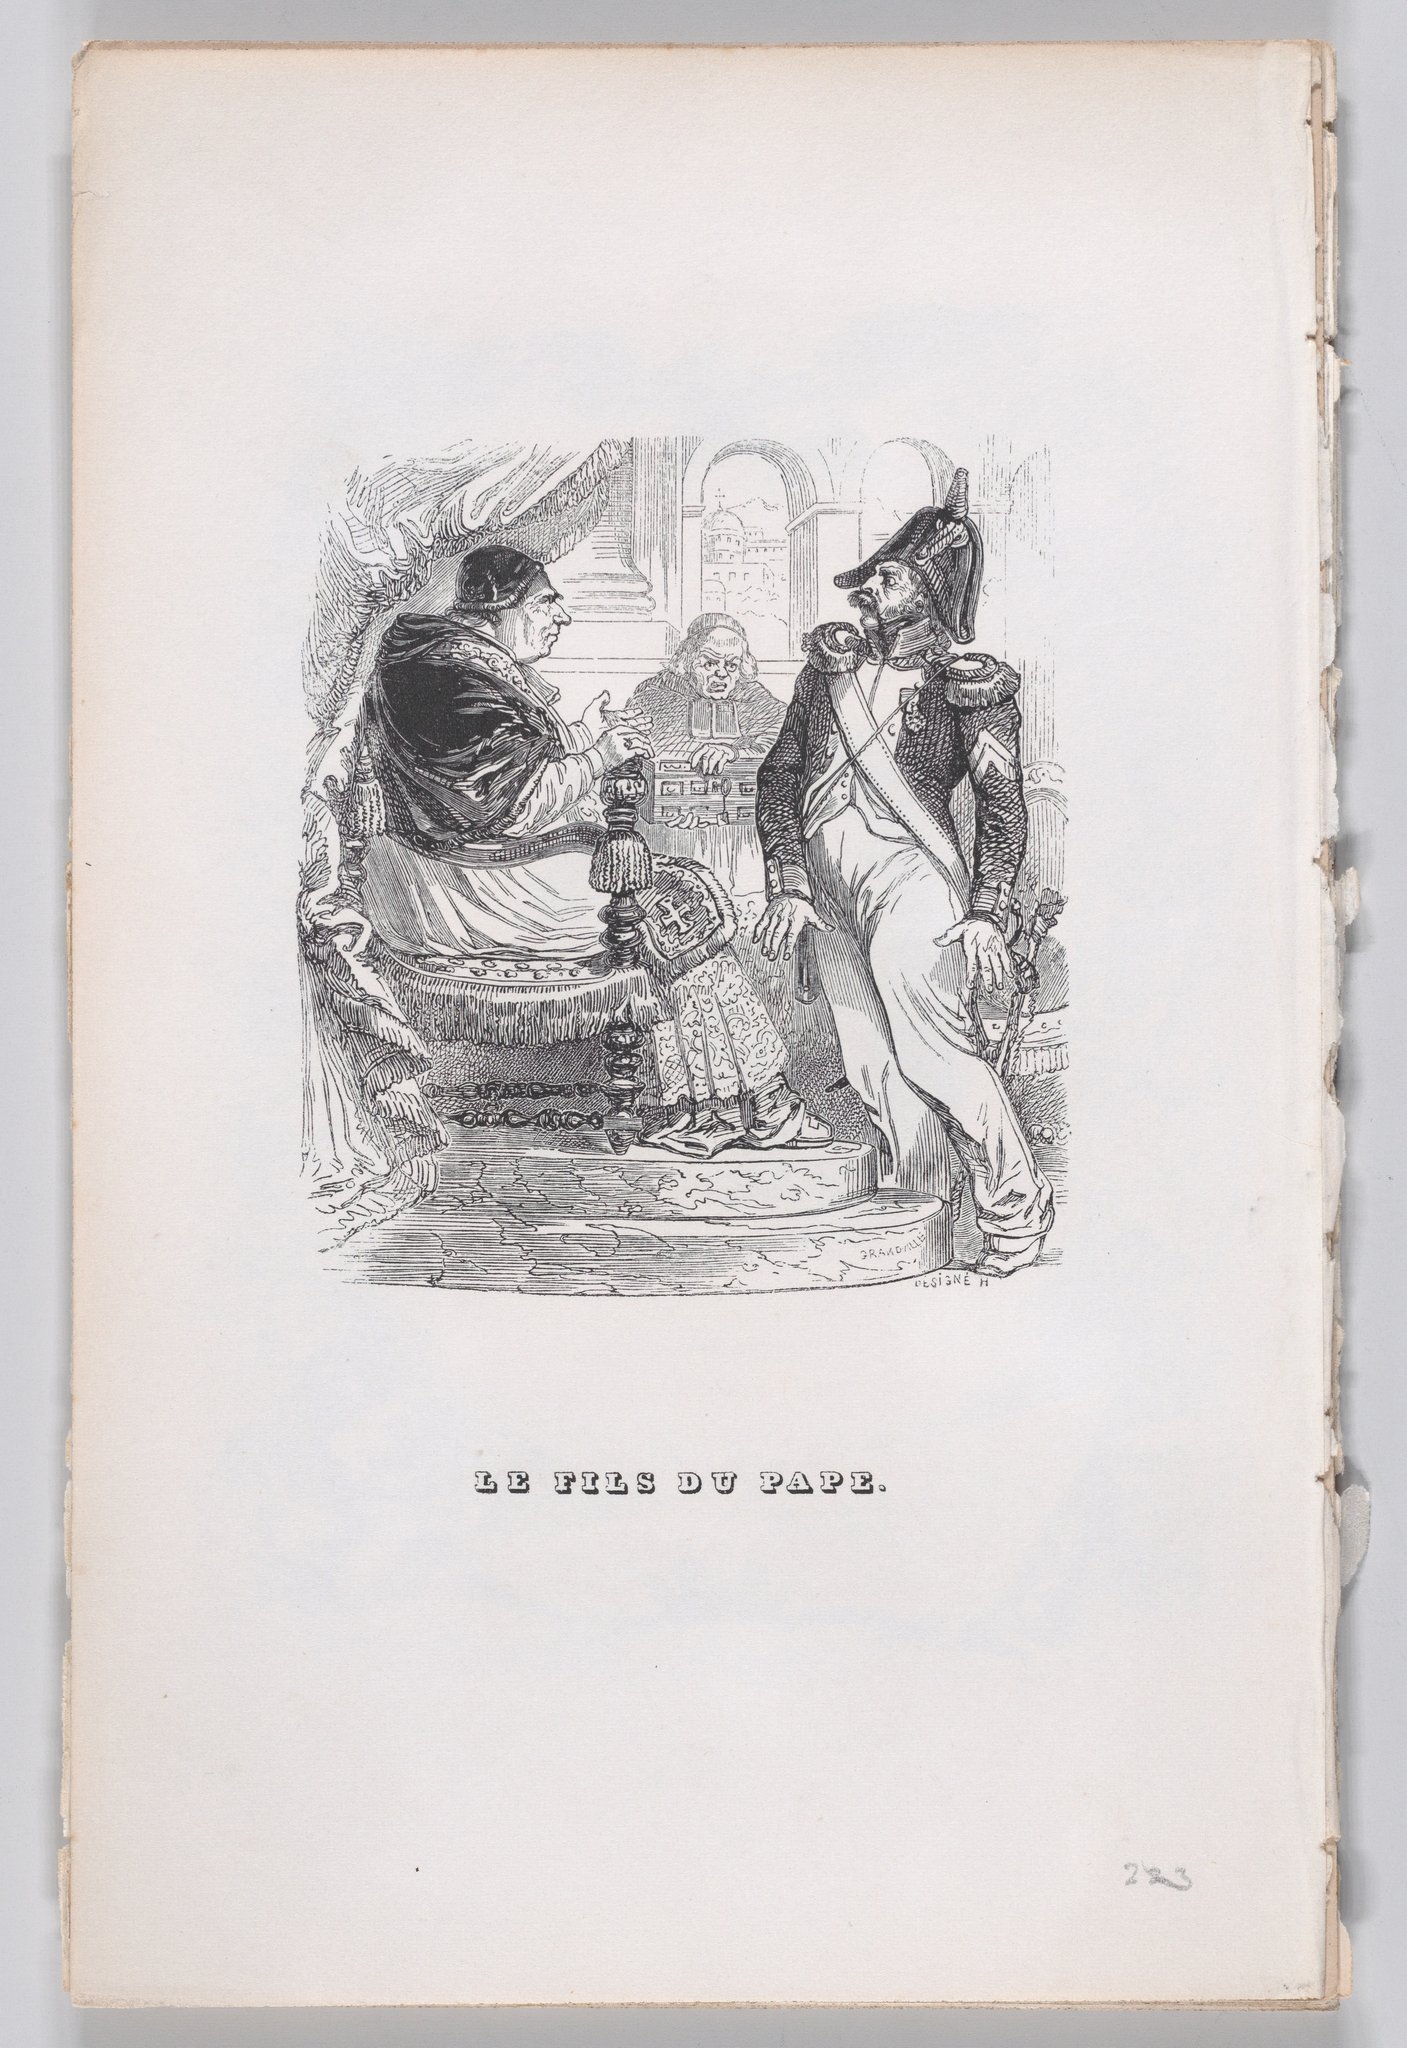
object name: print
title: The Son of the Pope, from "The Complete Works of Béranger"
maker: j. j. grandville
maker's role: illustrator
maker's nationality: french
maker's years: 1803-1847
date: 1836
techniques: engraving